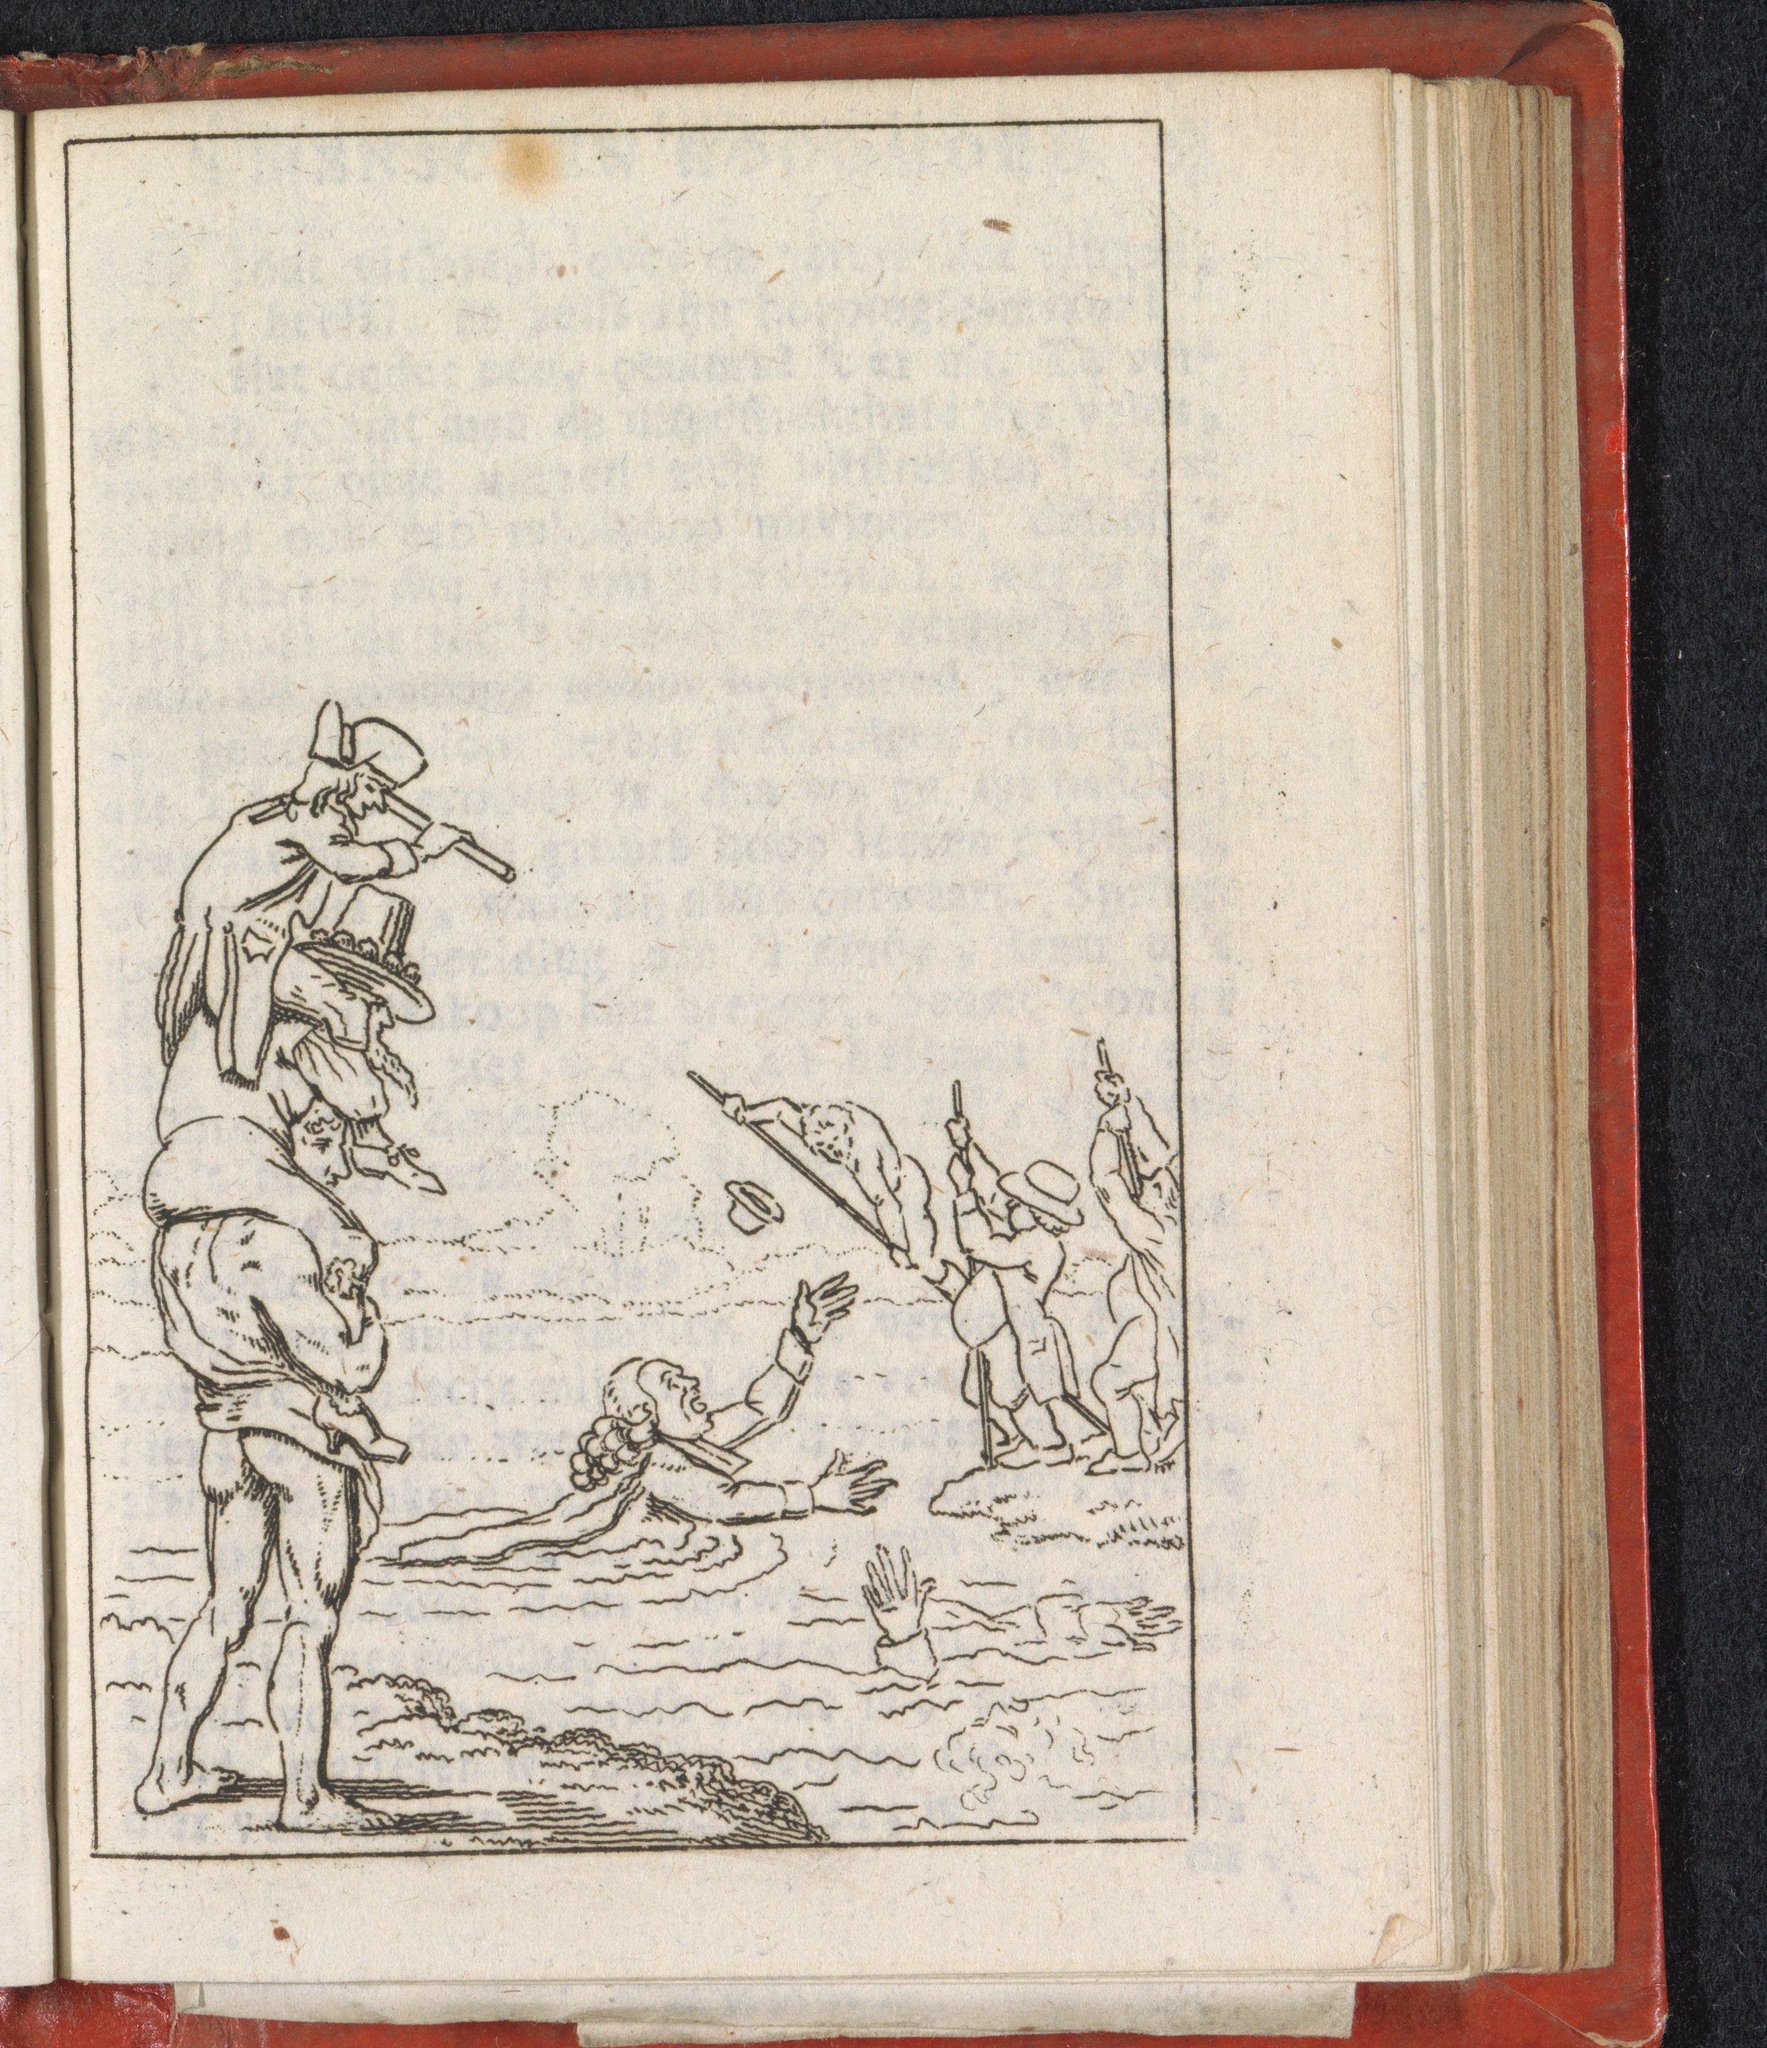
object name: cartoon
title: Predikant in het water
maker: pieter van woensel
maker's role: print maker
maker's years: 1747-1808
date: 1797-1798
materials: paper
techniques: etching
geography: netherlands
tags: ditch-over with jumping pole (jumping game), accidental death ~ water - ee - getting wounded by accident (death not involved)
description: Spotprent van een predikant als drenkeling in het water. Op de voorgrond kijken drie figuren zittend op elkaars schouders toe. Op de achtergrond een aantal personen aan het fierljeppen. Illustratie in Pieter van Woensels almanak 'De Lantaarn voor 1798'.